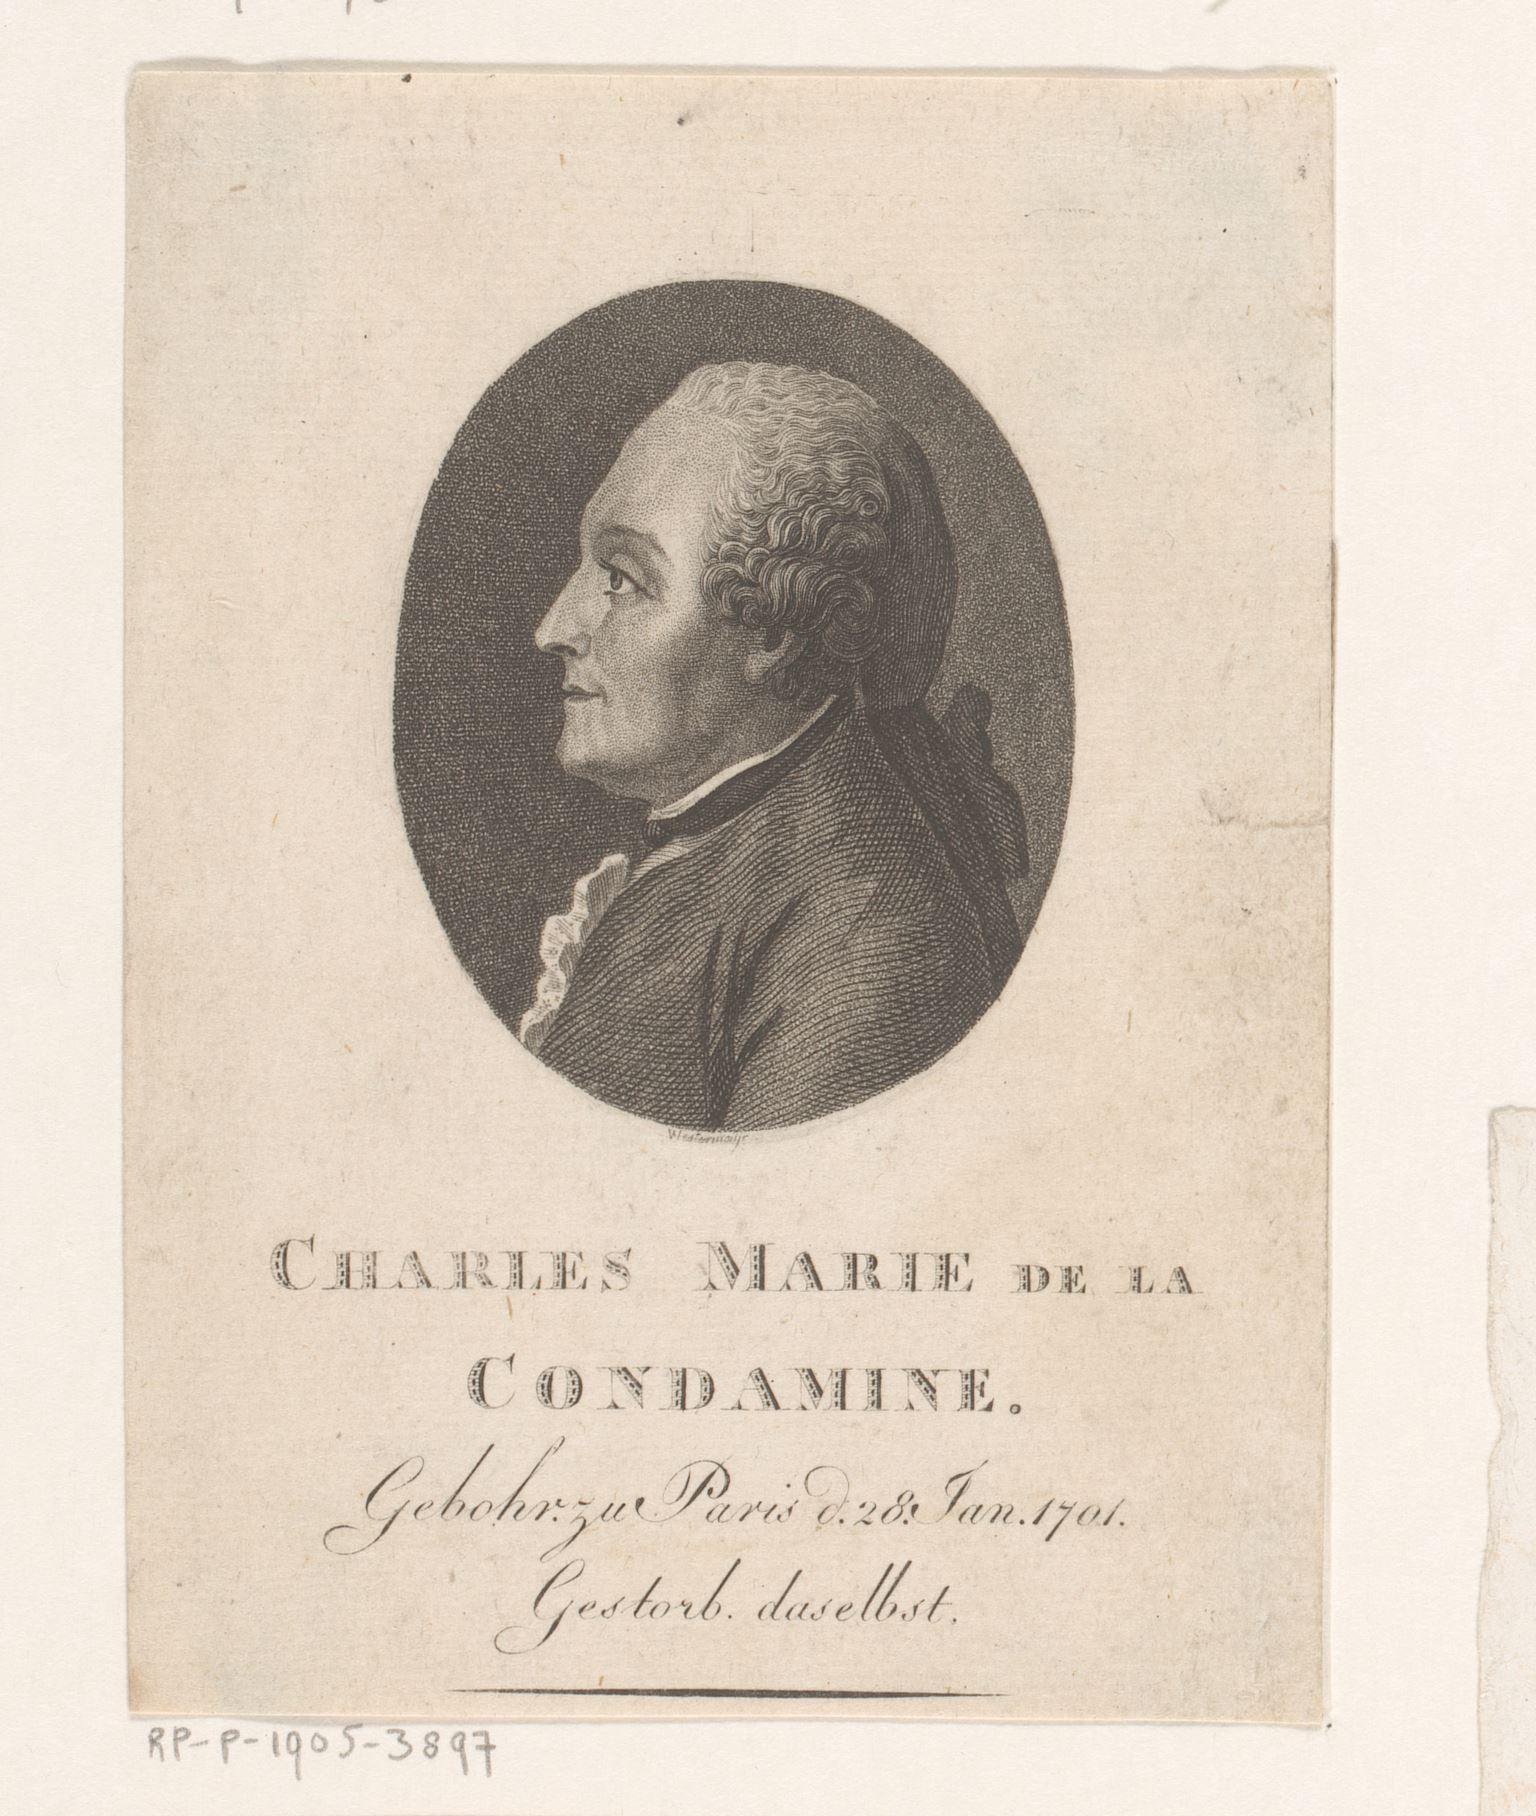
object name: print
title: Portret van Charles Marie de La Condamine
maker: konrad westermayr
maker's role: print maker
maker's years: 1765-1834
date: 1775-1834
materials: paper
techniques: engraving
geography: germany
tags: paris, historical persons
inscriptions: collector's mark: Lugt 2228